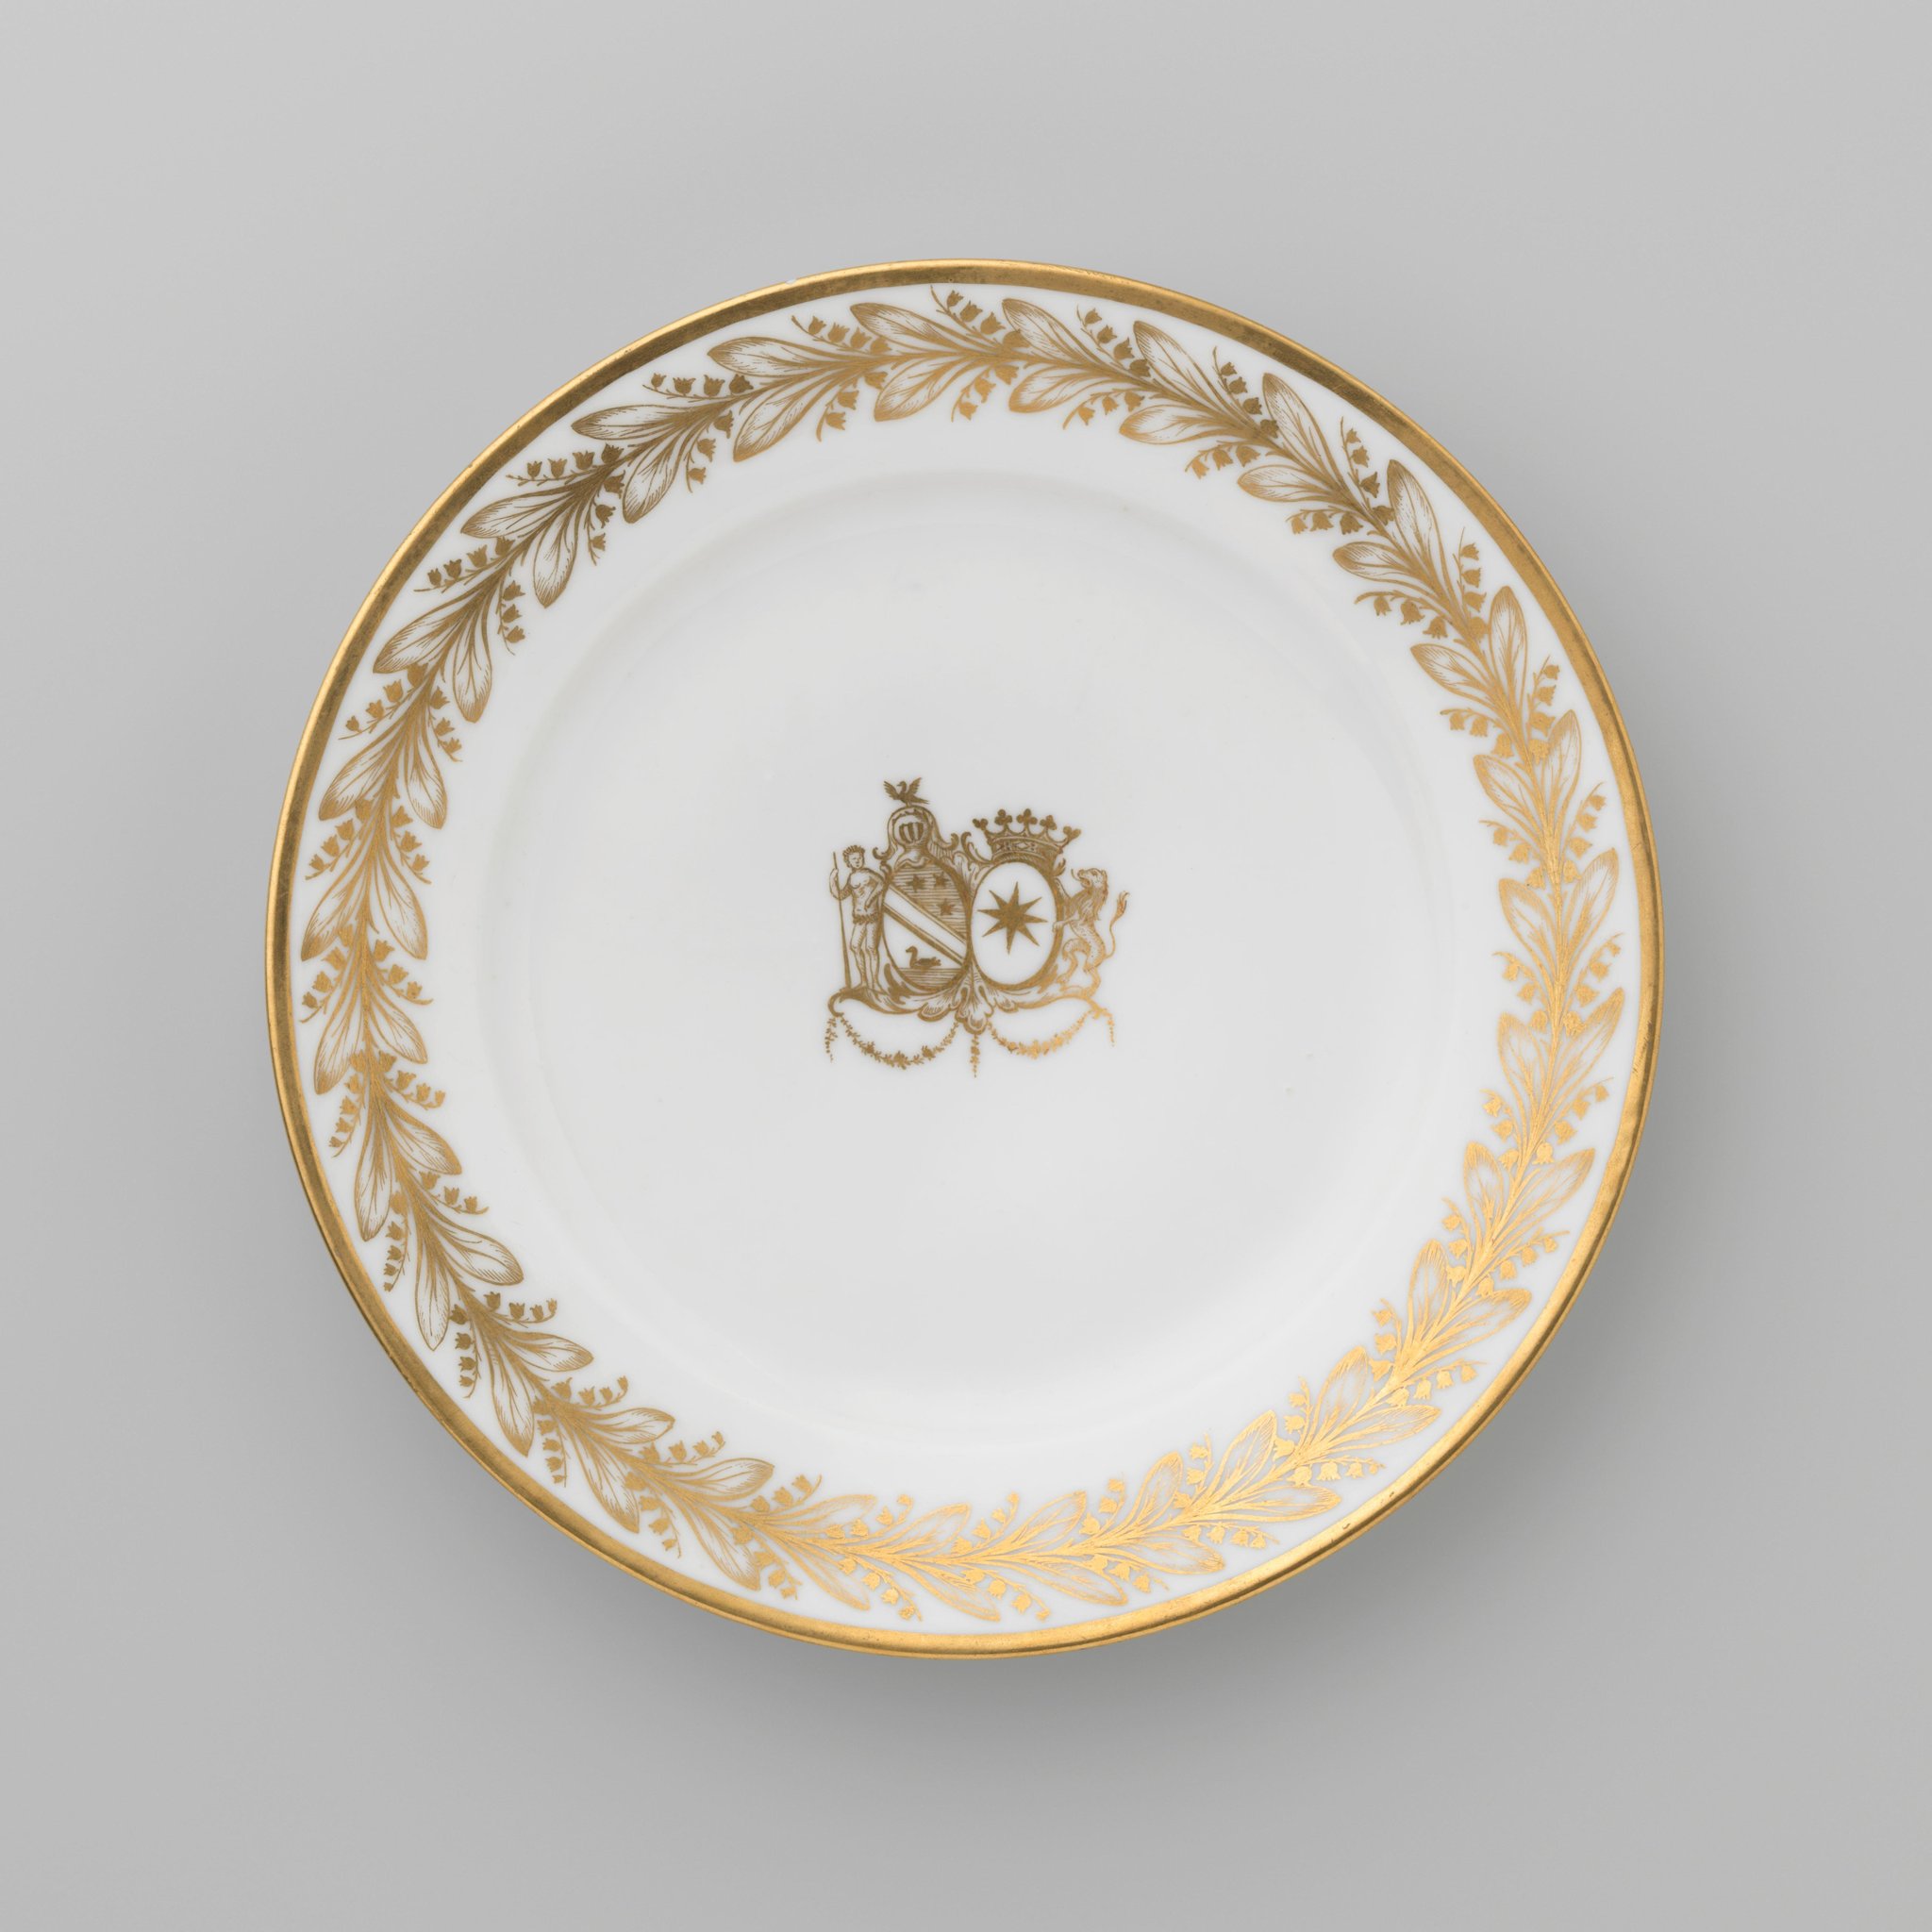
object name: service set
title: Plate with the coat of arms of Hendrik Peter Godfried Quack and Isabella Gertraud von Carnap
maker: Anonymous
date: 1790-1800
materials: glaze, gold, paint, porcelain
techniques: firing, forming, gilding, turning, vitrification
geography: paris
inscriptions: mark: ‘I:B:W’, mark: ‘L’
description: Bord van porselein, rond model, behorend bij een servies met versiering in goud van een bloem- en bladkrans en met het alliantiewapen van Hendrik Peter Godfried Quack en Isabella Gertraud von Carnap. Het bord heeft een kleiner en wat afwijkend wapen dan op de rest van het servies. Ook de decoratie is iets anders. Gemerkt met ingegrifte letter L en in goud: I:b:W.